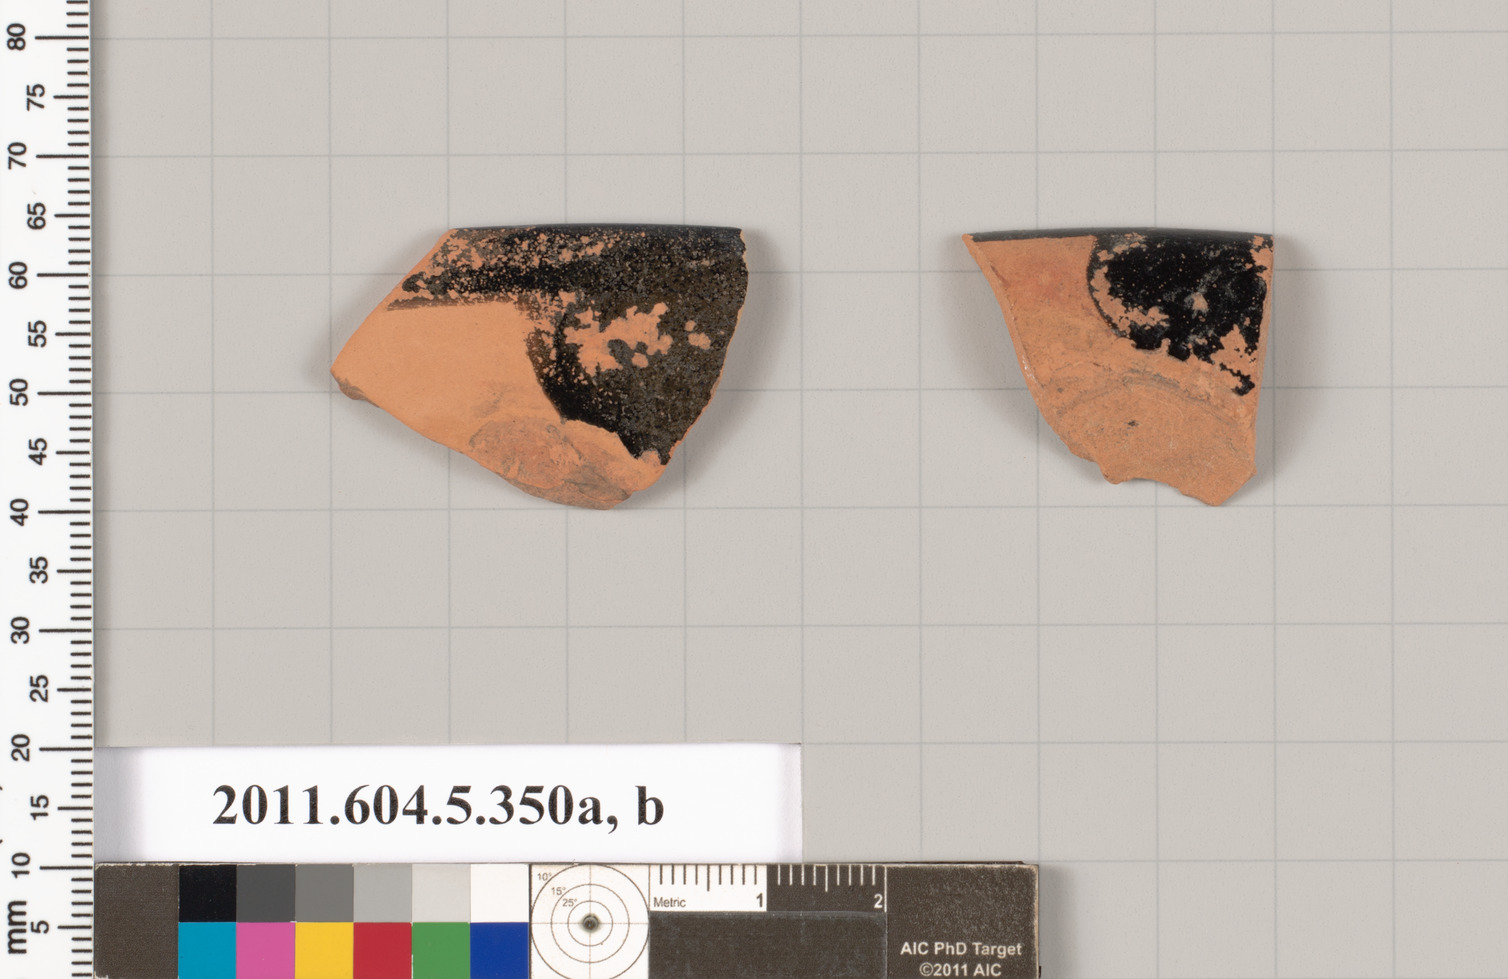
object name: kylix fragment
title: Terracotta rim fragments of kylikes (drinking cups)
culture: greek, attic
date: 600-401 BCE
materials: terracotta